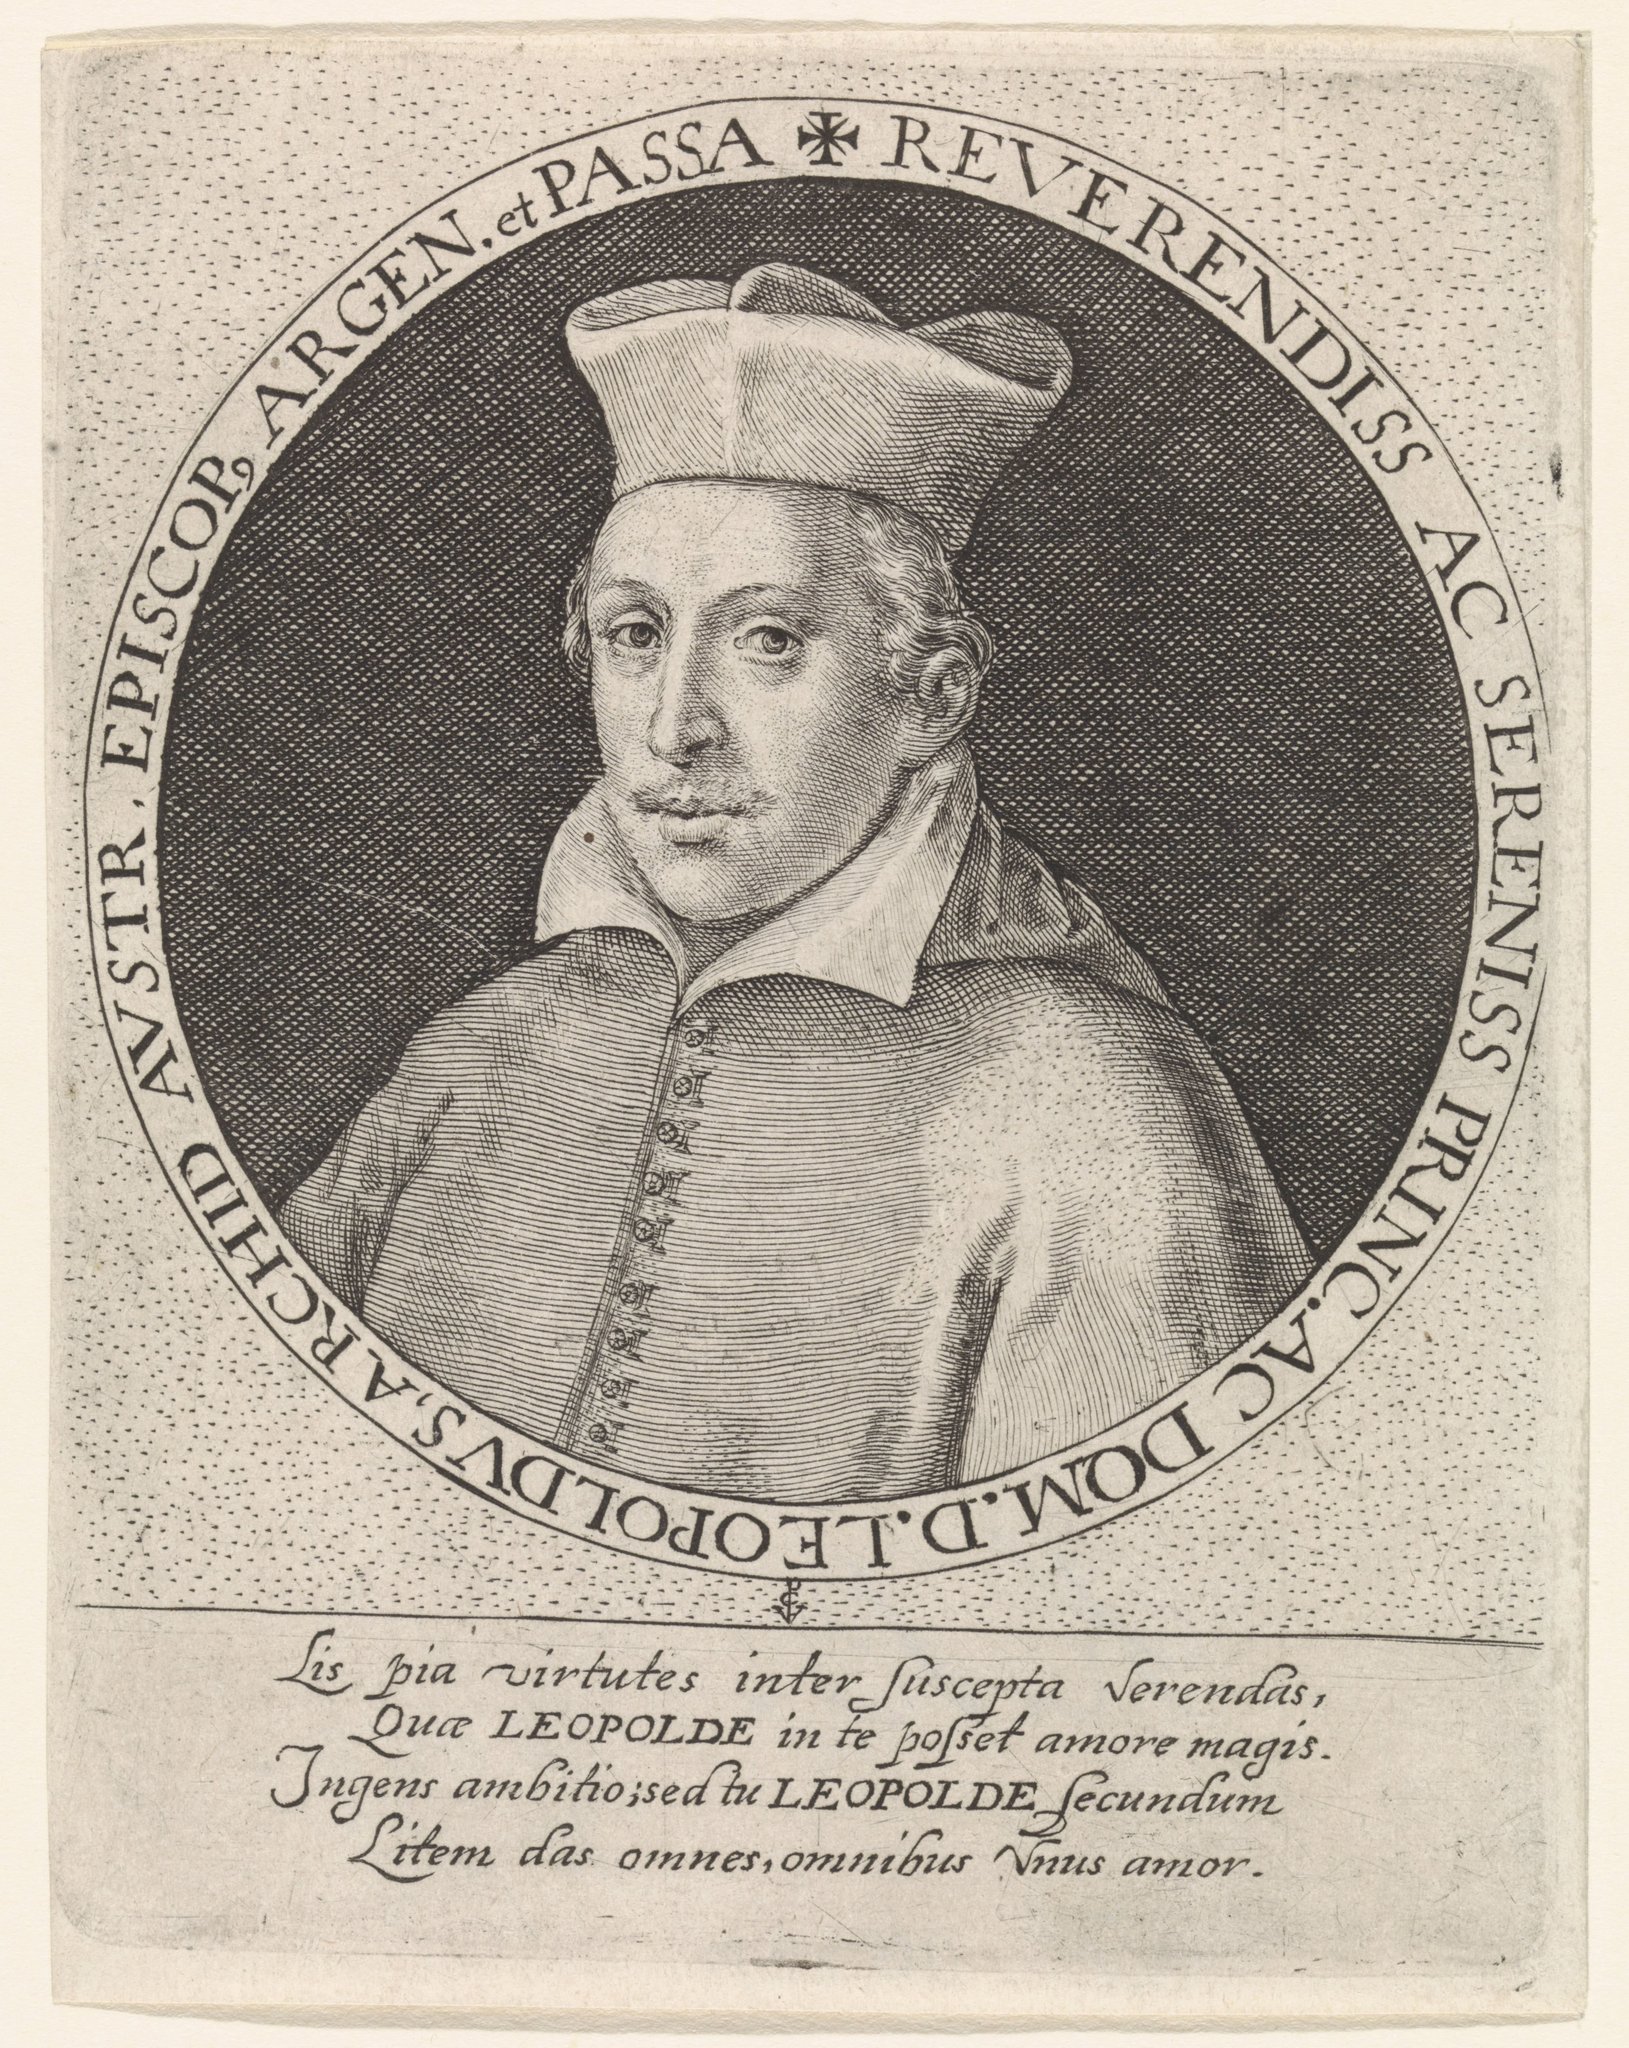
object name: print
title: Portret van Leopold Willem van Oostenrijk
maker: crispijn van de passe (i)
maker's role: draughtsman, print maker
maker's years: 1564-1637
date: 1610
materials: paper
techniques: engraving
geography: cologne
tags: vienna, leopold willem van oostenrijk (landvoogd der zuidelijke nederlanden), cardinal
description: Portret van Leopold Willem van Oostenrijk, landvoogd der Zuidelijke Nederlanden, als kardinaal. In het randschrift van de omlijsting de naam en functie van de geportretteerde in het Latijn. In de marge een vierregelig lofdicht in het Latijn.